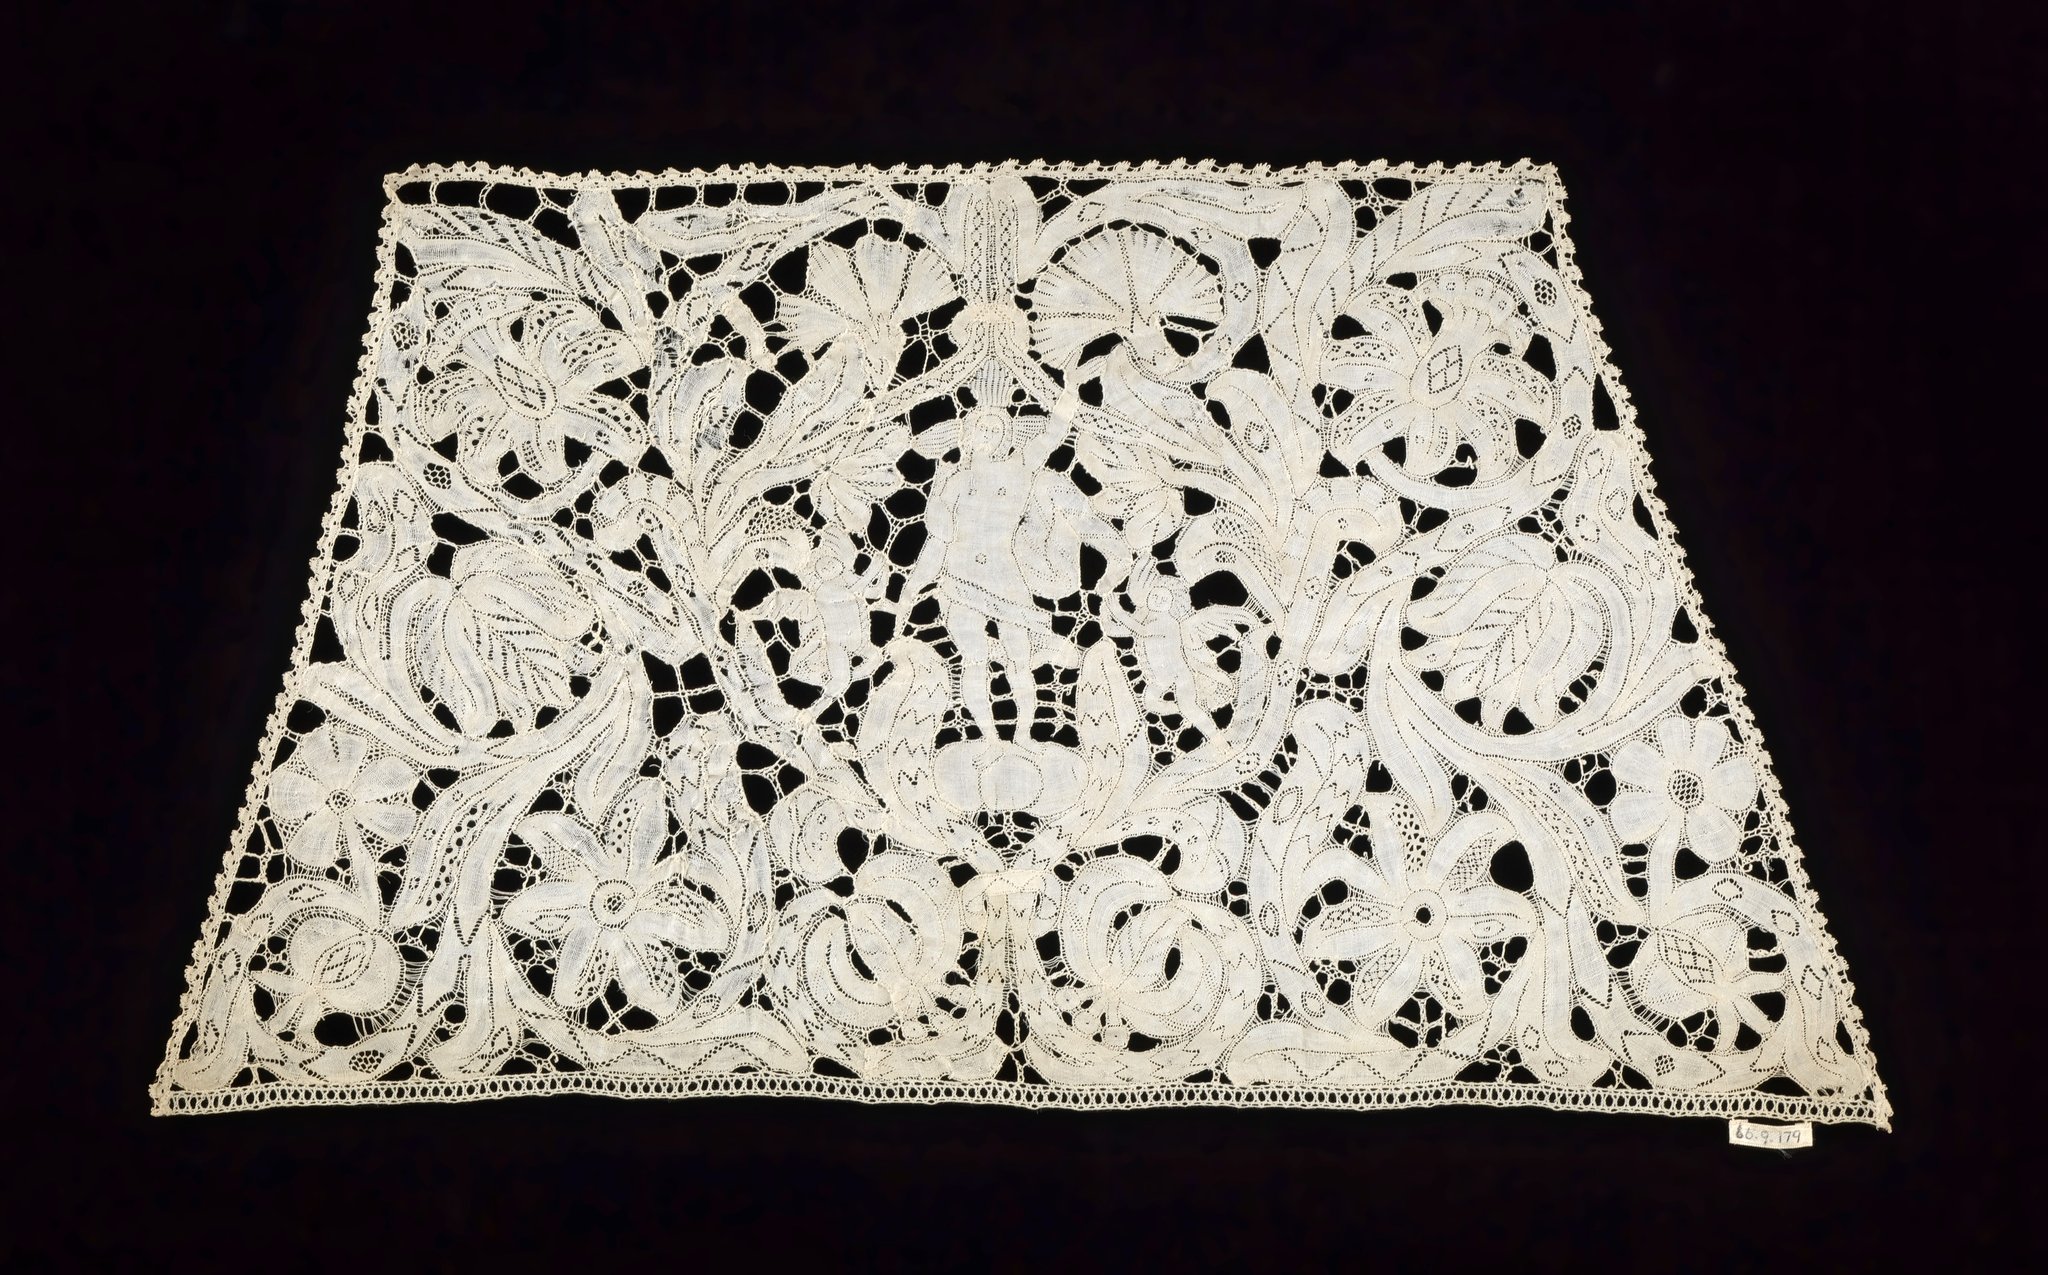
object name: cuff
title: Cuffs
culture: flemish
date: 1667-1700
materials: linen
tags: men